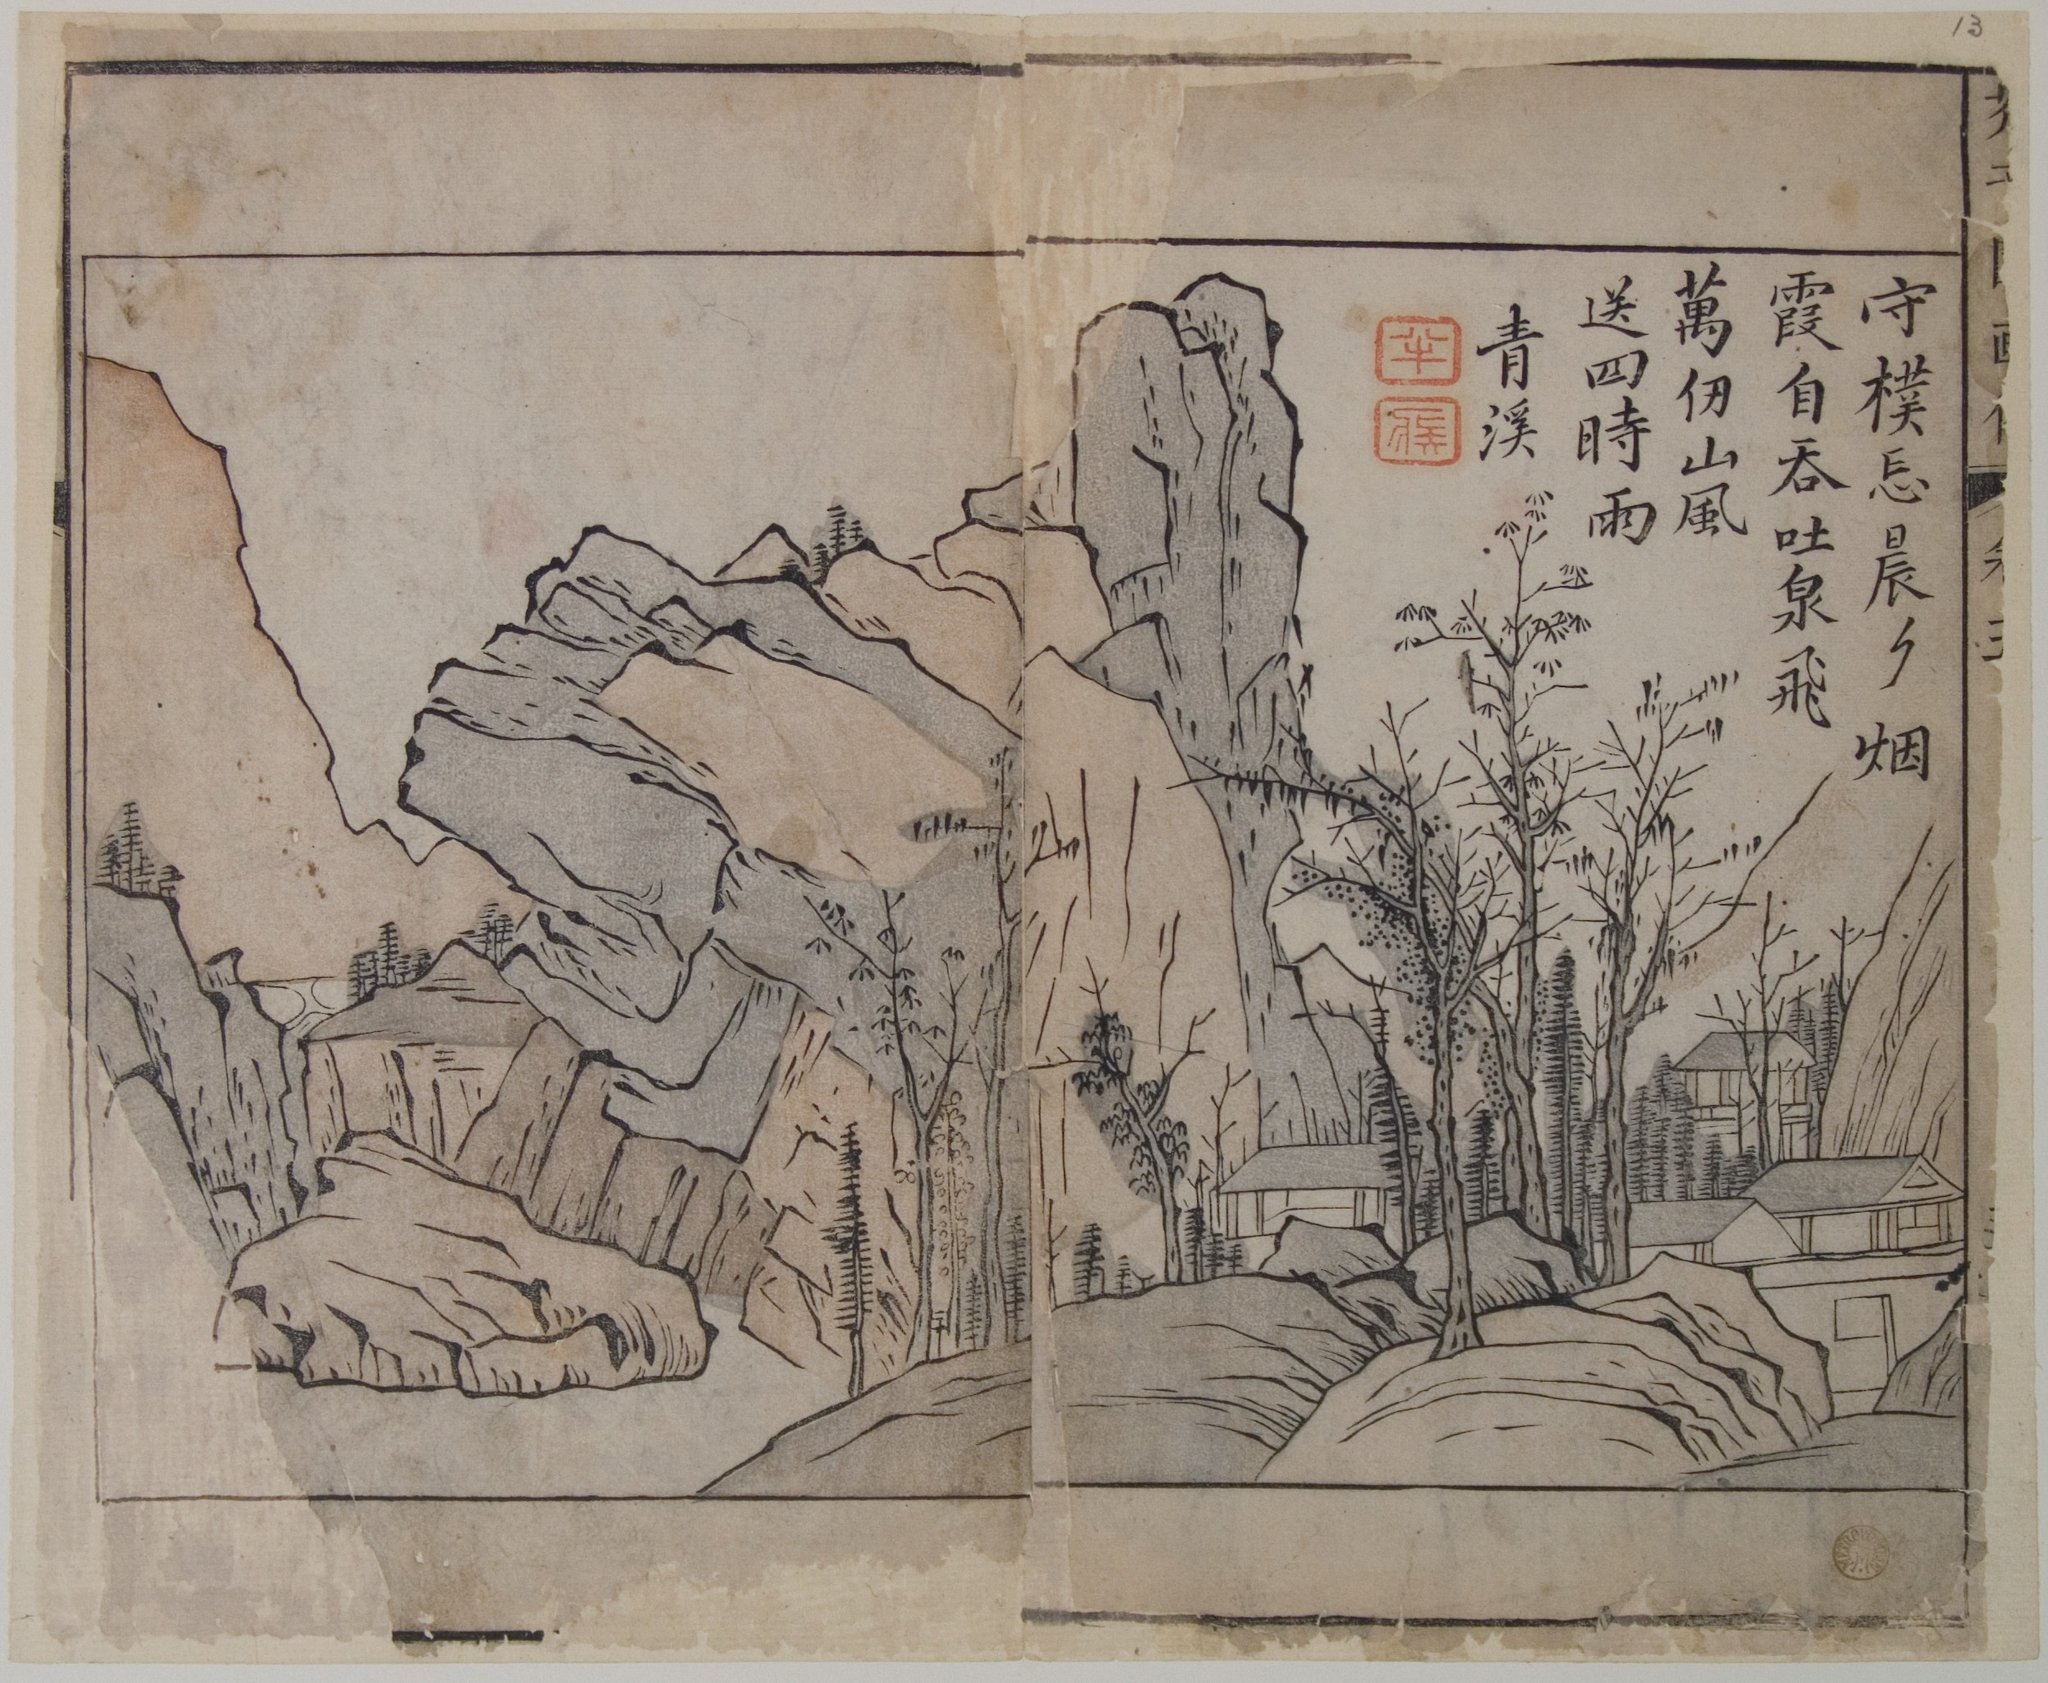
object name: print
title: Page from the Mustard Seed Garden Manual of Painting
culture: chinese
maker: wang gai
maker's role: artist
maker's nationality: chinese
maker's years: 1645-1710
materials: ink, paper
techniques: woodblock print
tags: houses,mountains